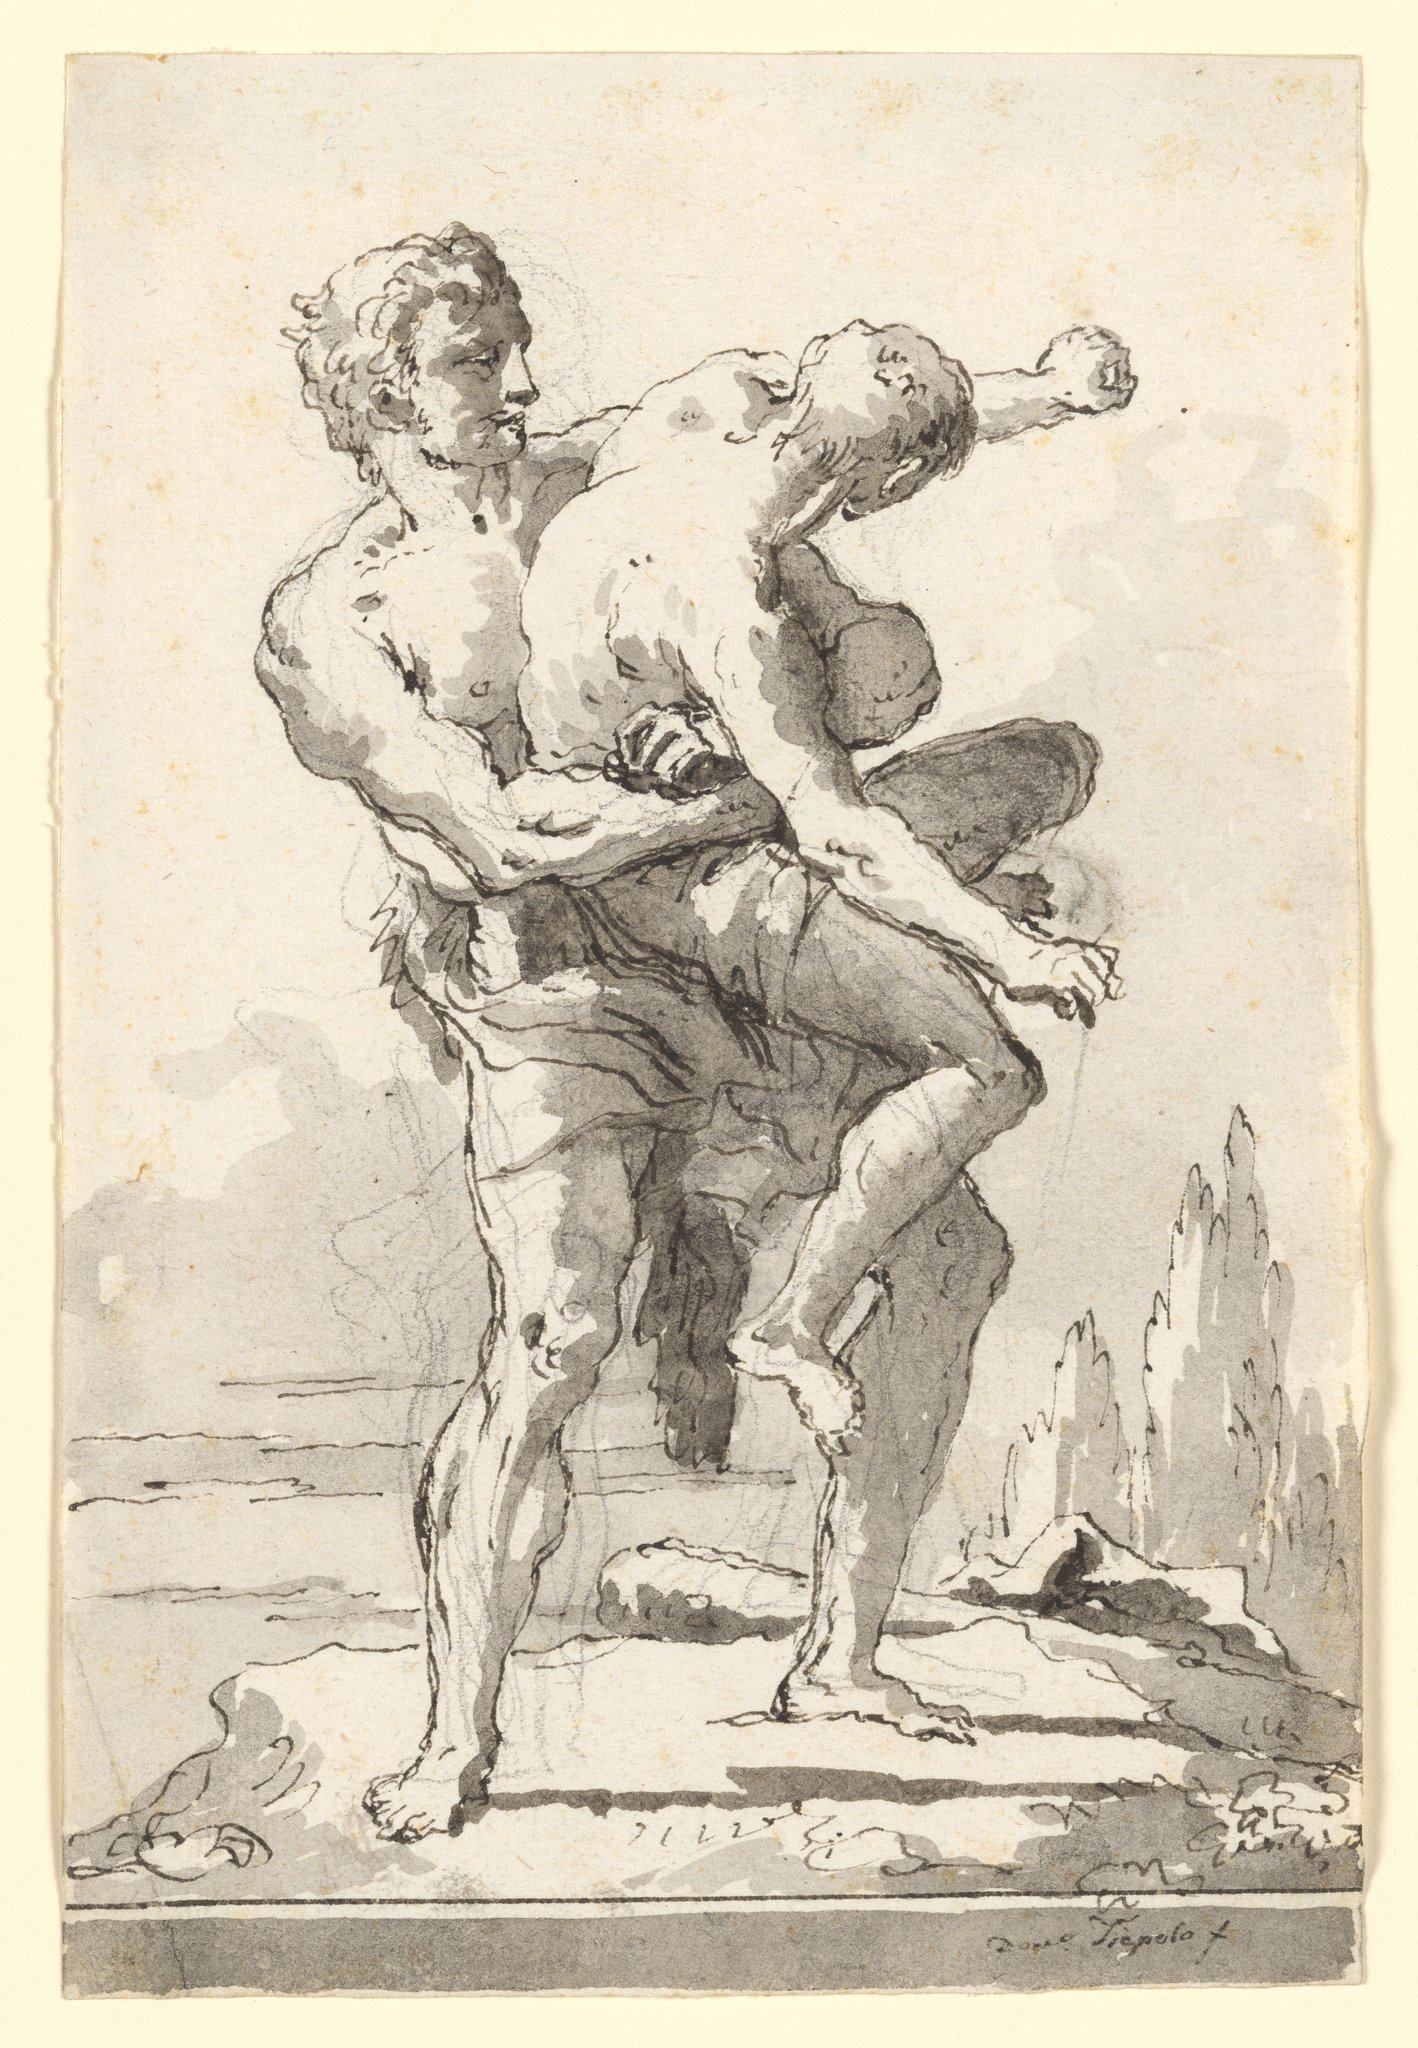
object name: drawing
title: Hercules and Antaeus (with a ledge Below)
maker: giovanni domenico tiepolo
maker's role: artist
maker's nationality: italian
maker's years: 1727-1804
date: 1767-1800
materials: chalk, ink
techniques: pen, wash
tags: men,hercules